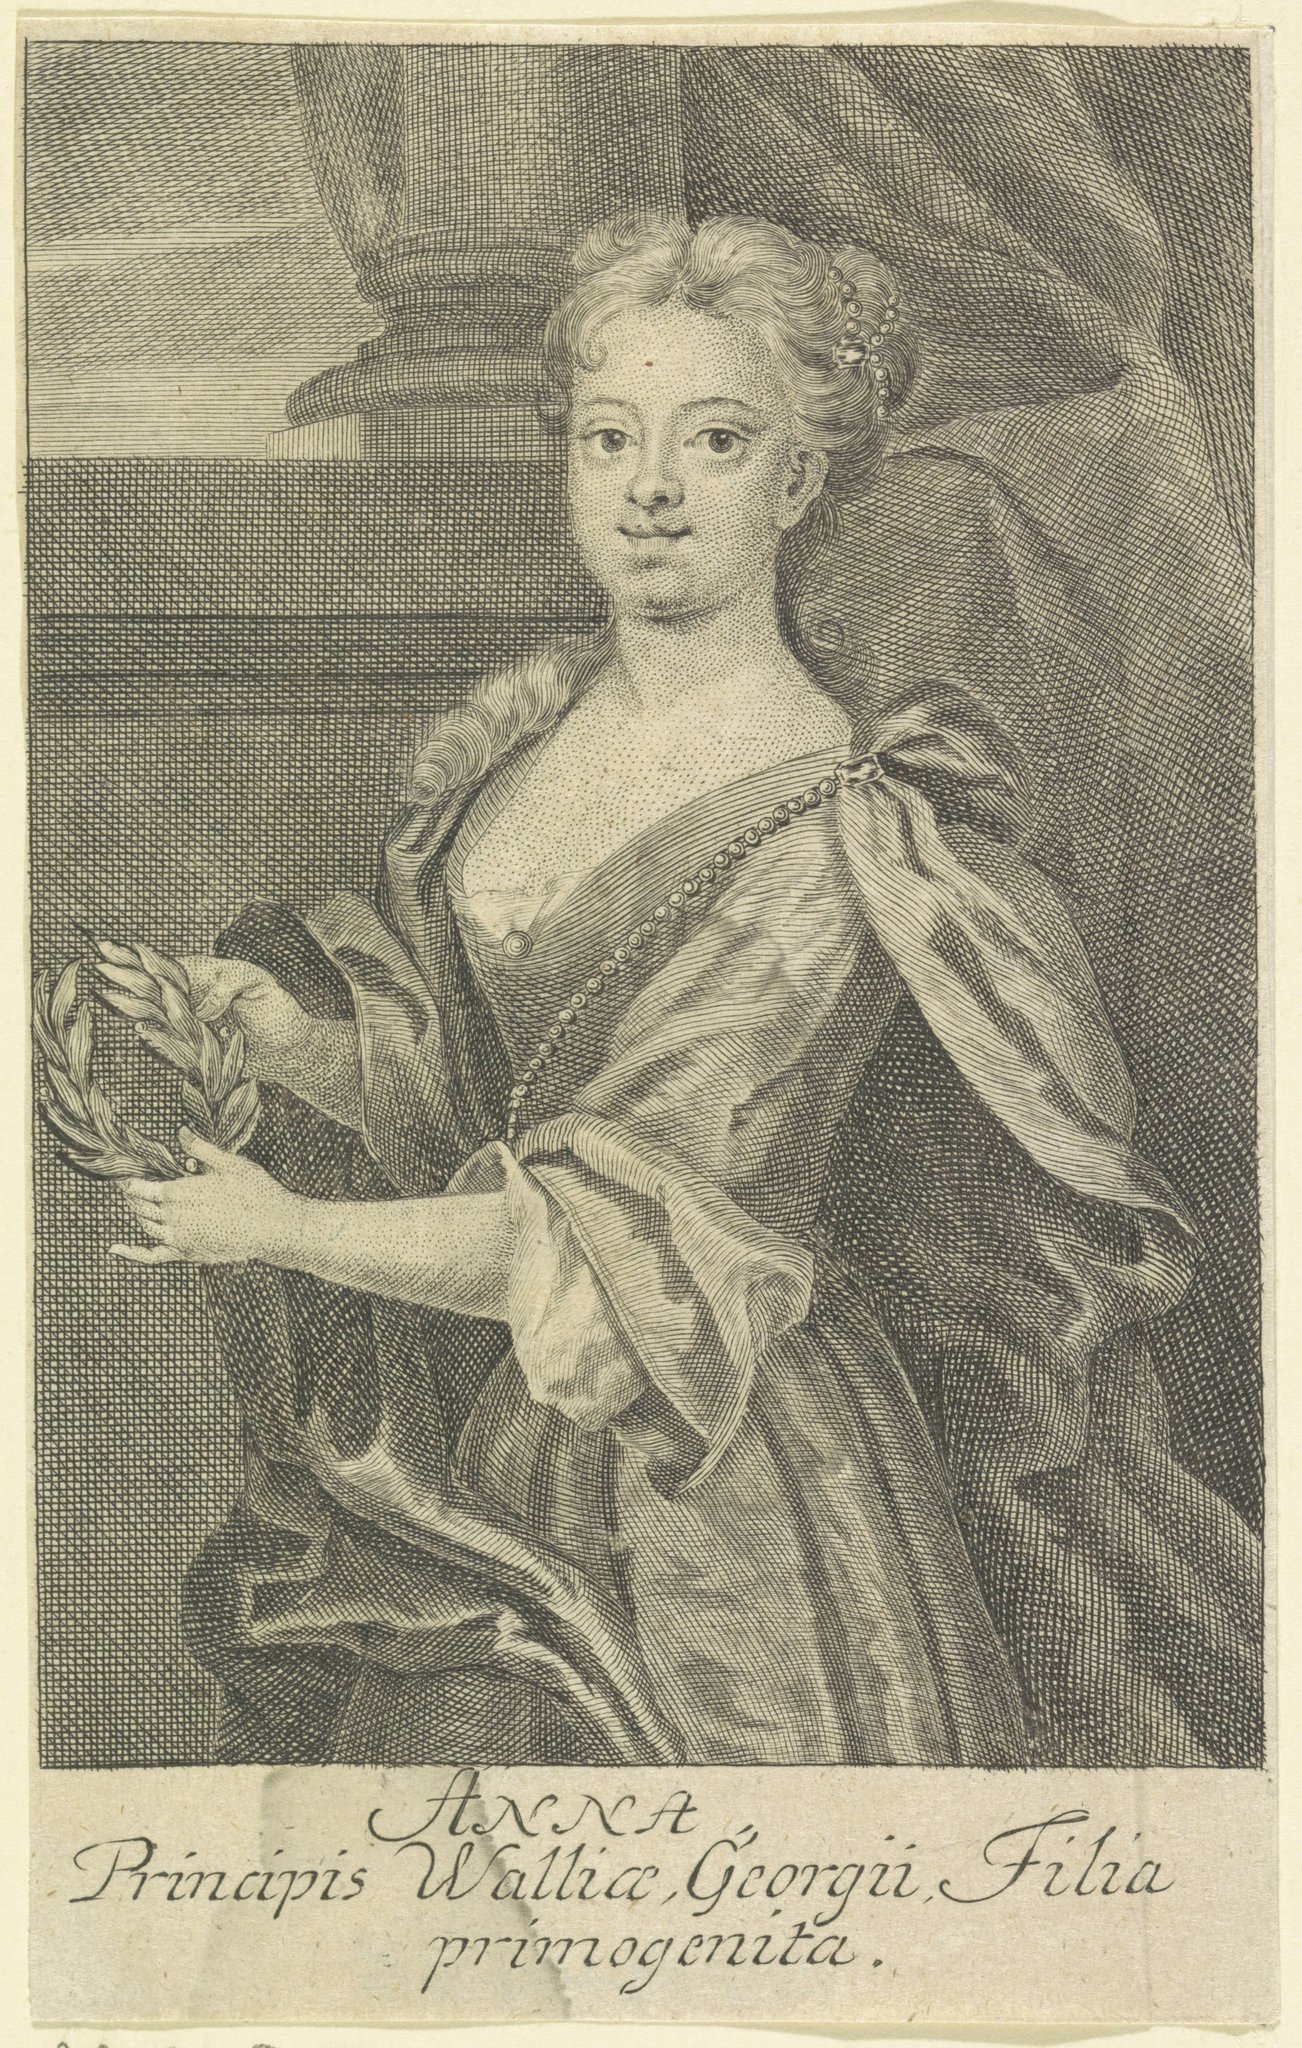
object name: print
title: Portret van Anna van Hannover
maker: Anonymous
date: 1715-1799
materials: paper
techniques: engraving, etching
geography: low countries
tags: the hague, anna van hannover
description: Portret van Anna. In haar handen een lauwerkrans. In de ondermarge haar naam en titels.